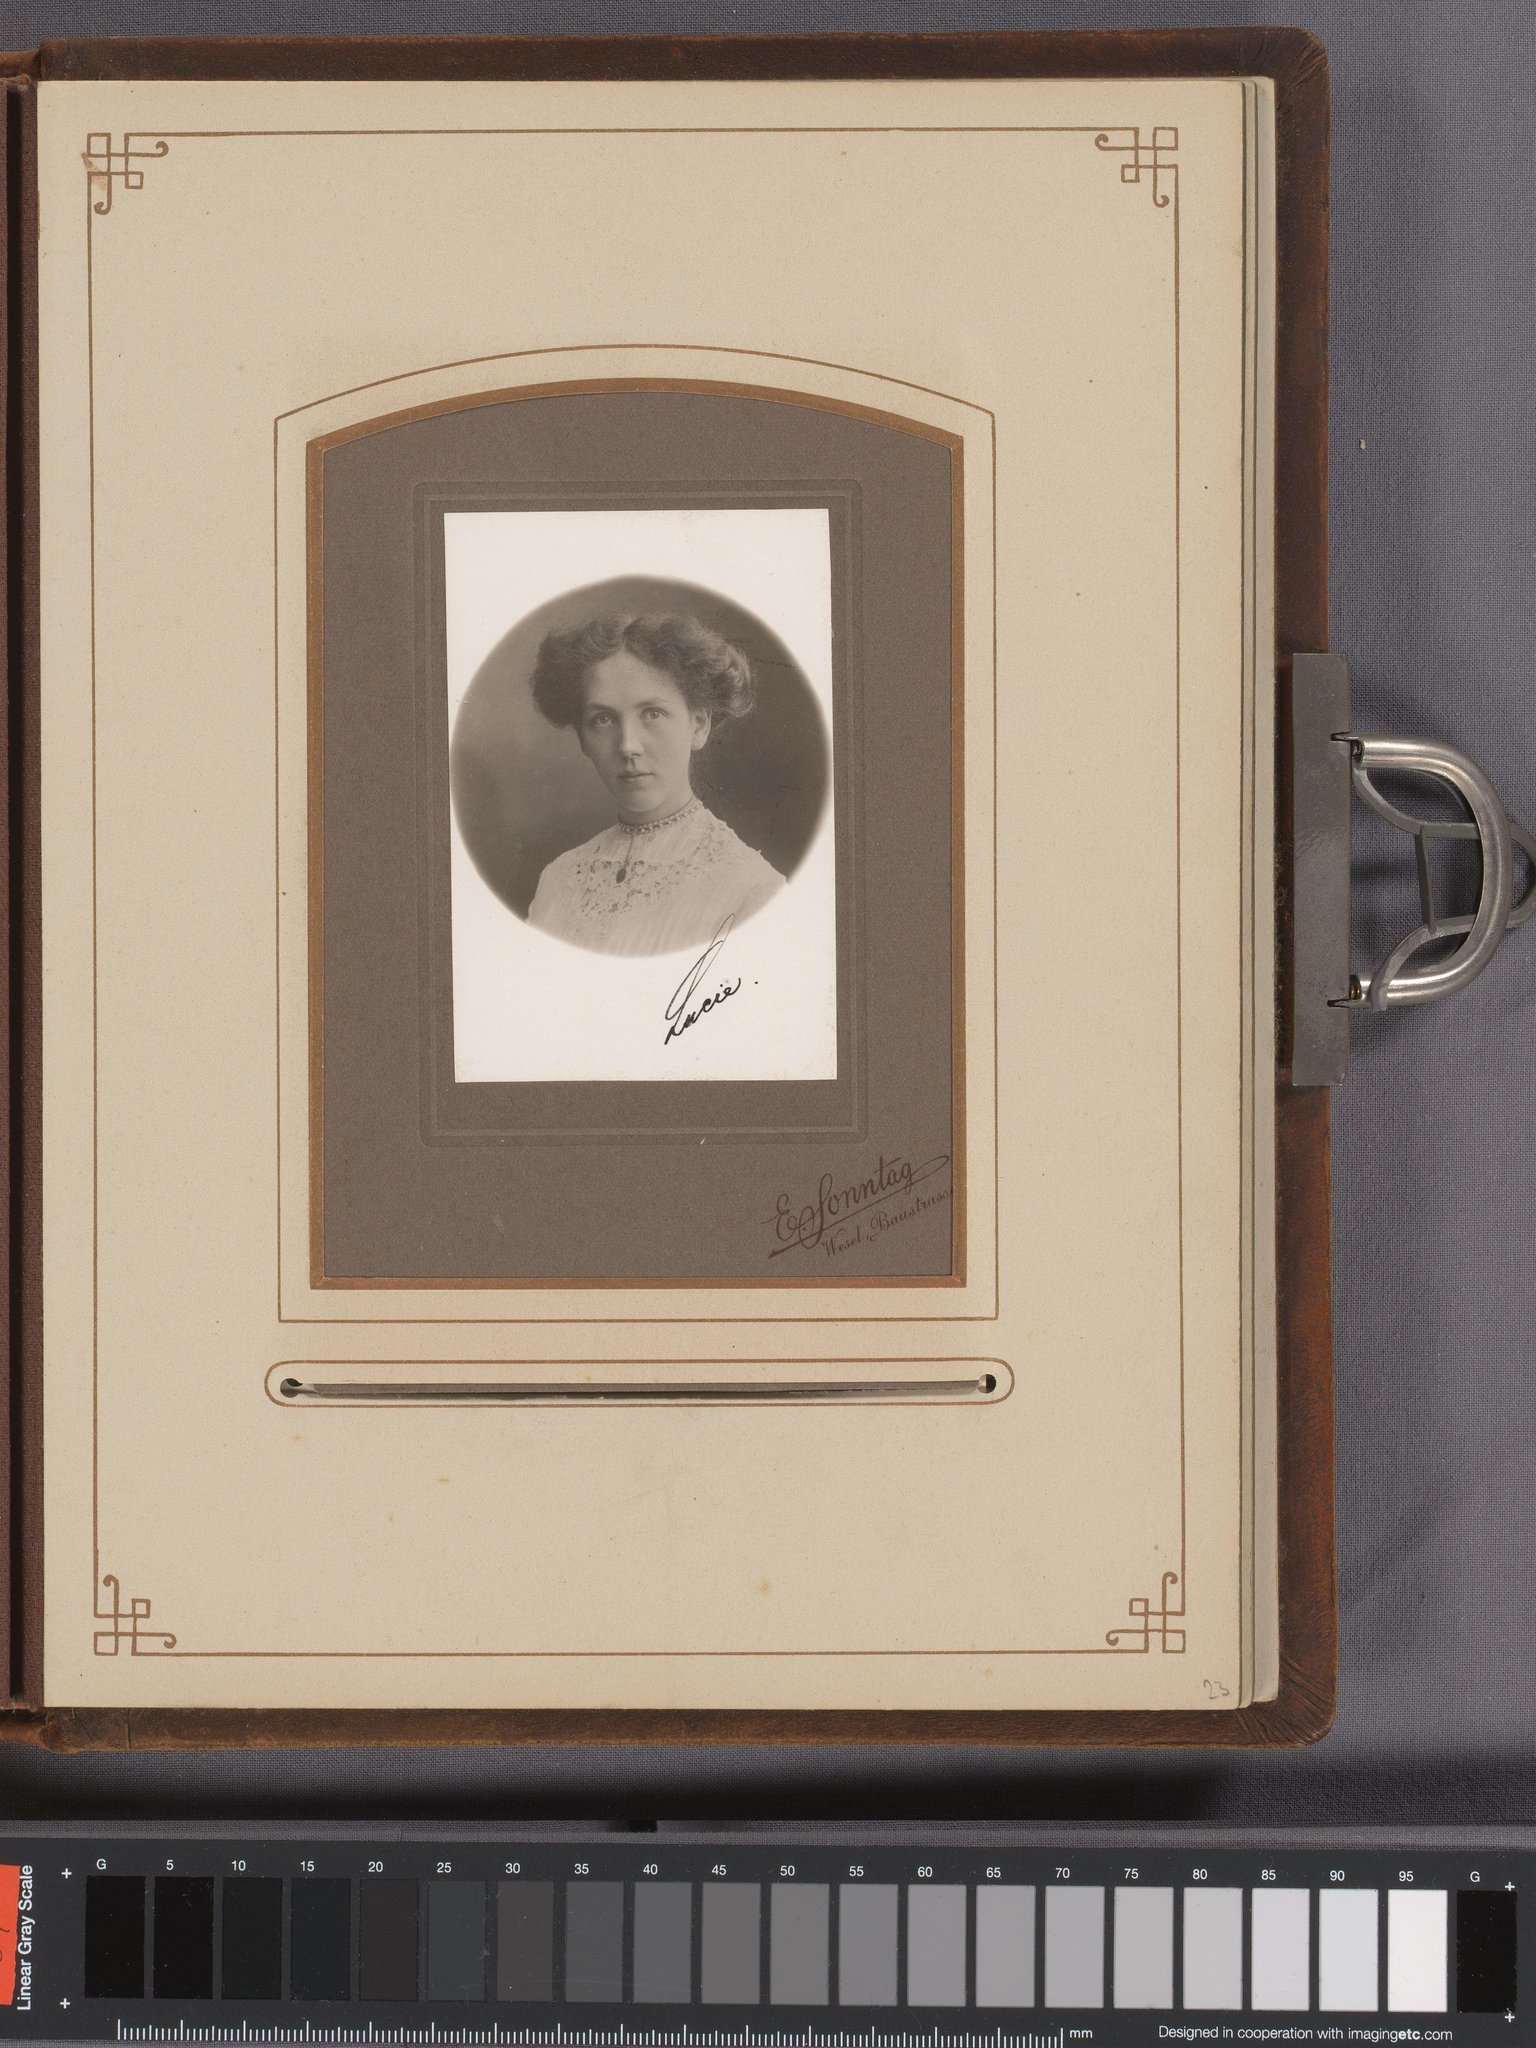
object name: photograph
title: Portret van een vrouw, aangeduid als Lucie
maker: ernst sonntag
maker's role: fotograaf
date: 1888-1896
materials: cardboard, photographic support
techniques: collodion silver print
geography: dresden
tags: historical persons - bb - woman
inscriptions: inscription: ‘E. Sonntag/ Wesel Baustrasse’, name: ‘Lucie’